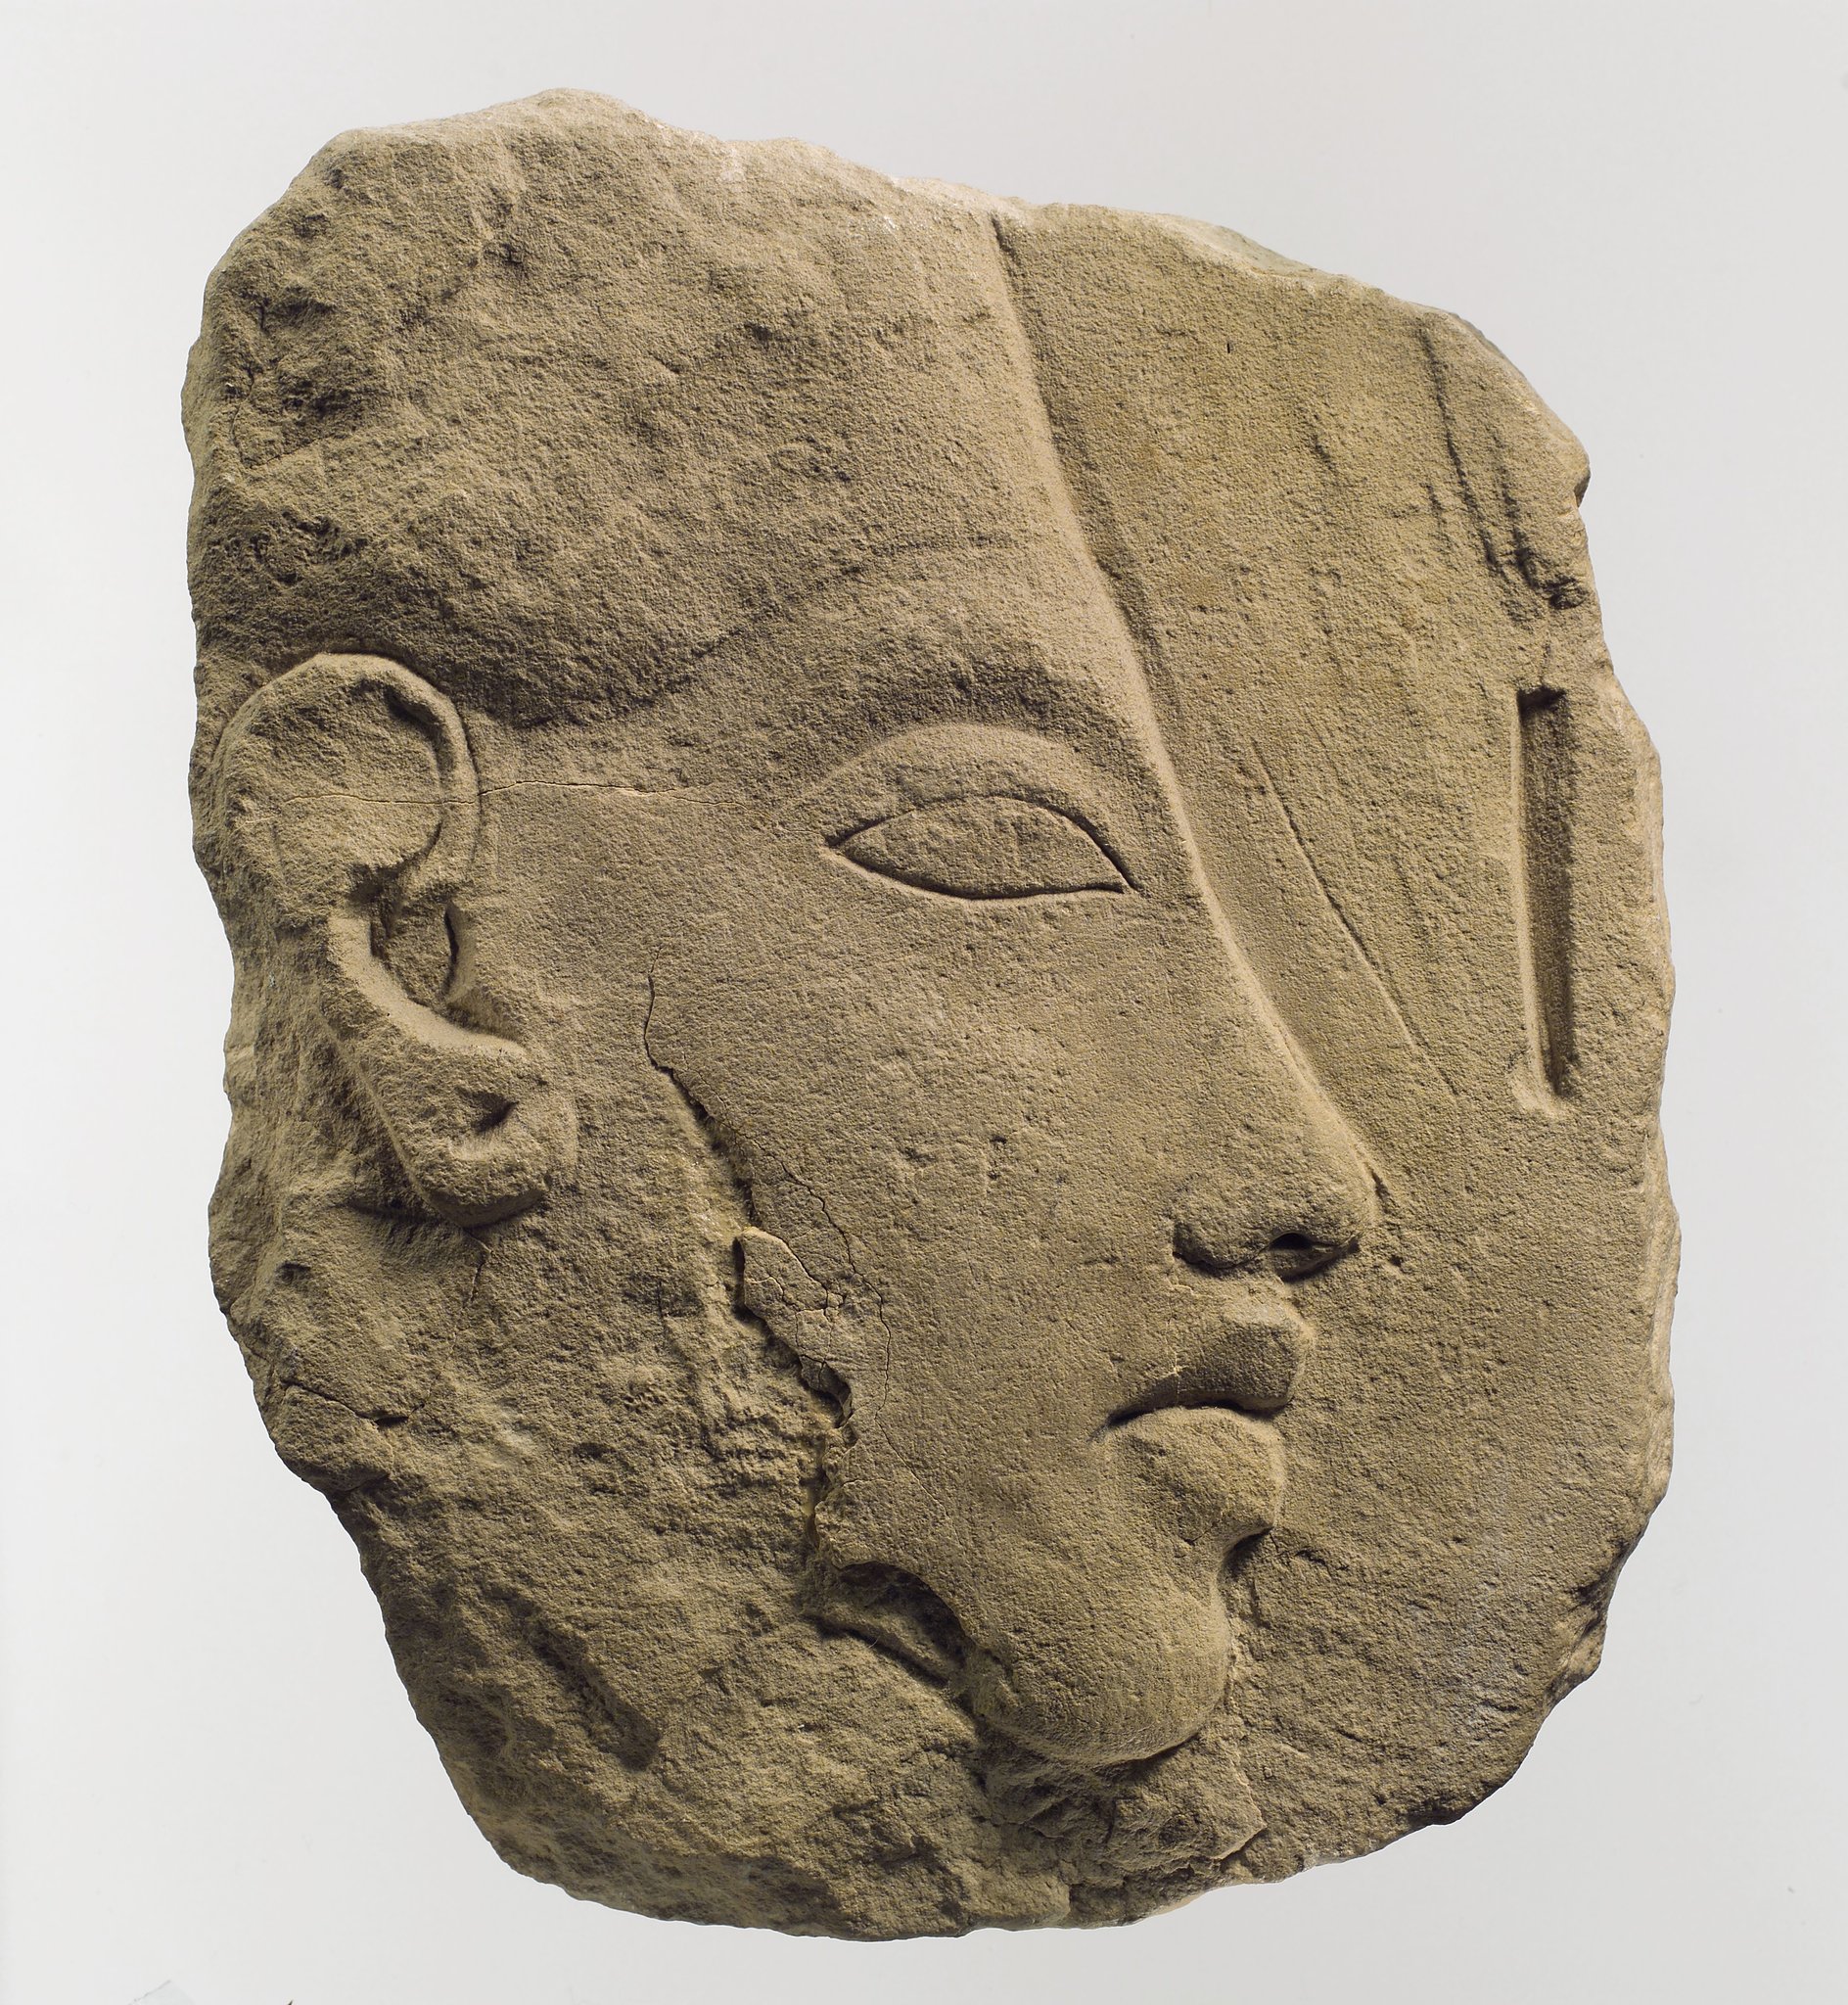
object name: trial piece, akhenaten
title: Trial piece of Akhenaten, on the reverse a horse's head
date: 1353-1336 BCE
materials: limestone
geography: egypt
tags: kings